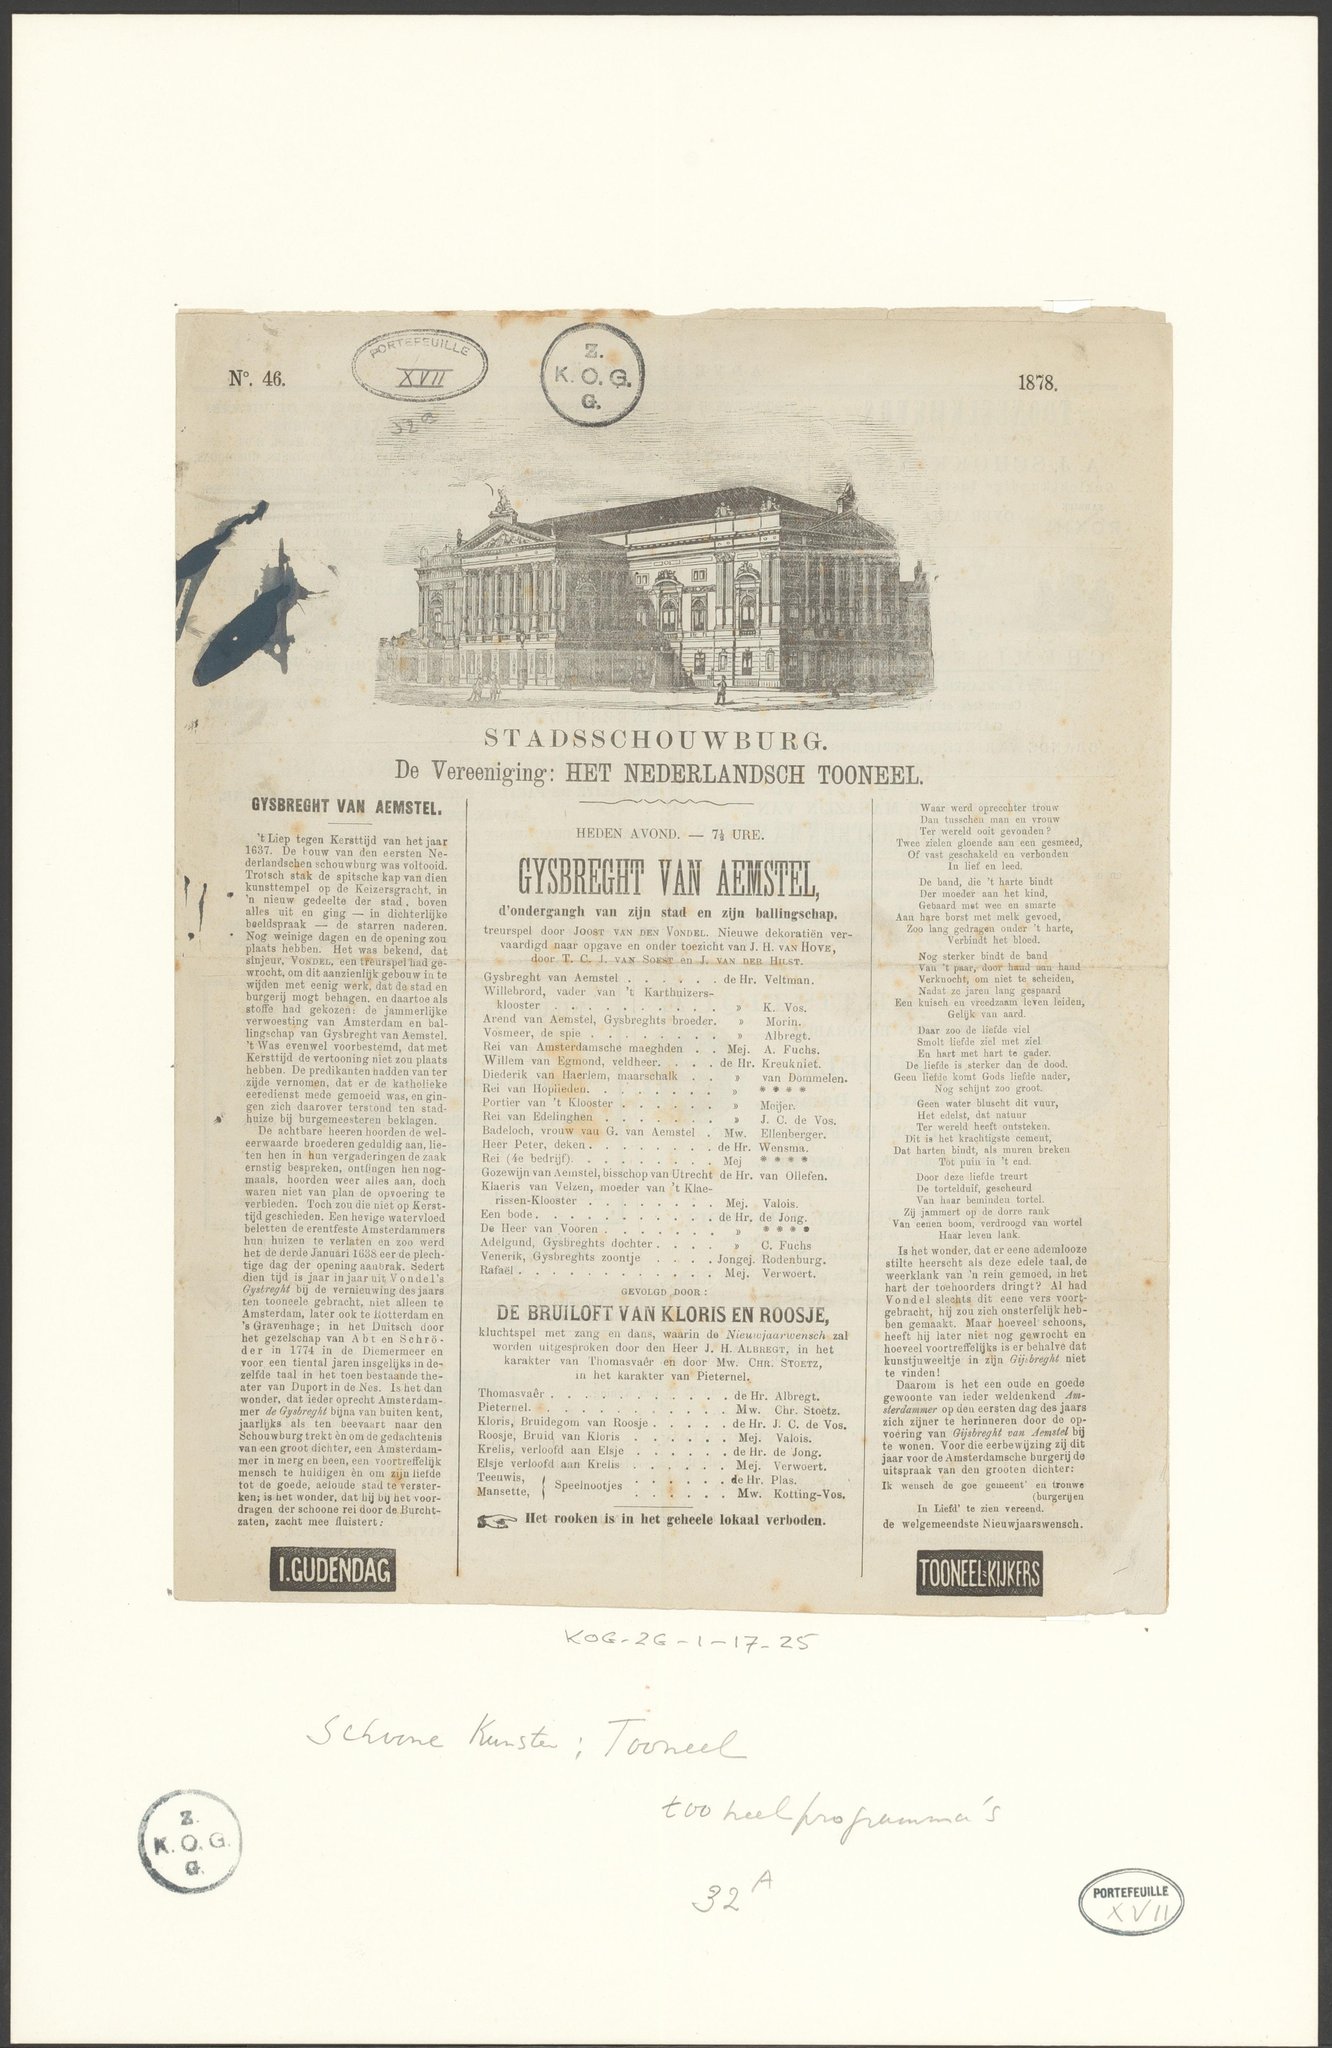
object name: print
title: Aankondiging van de voorstelling Gijsbreght van Aemstel en De bruiloft van Kloris en Roosje, 1878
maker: Anonymous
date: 1878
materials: paper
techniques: letterpress printing, engraving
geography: amsterdam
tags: theatre, theatrical performance, advertisement, notice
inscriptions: collector's mark: Lugt 1641, stamp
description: Een in elkaar gevouwen blad vormt vier pagina's. Op de eerste pagina een aankondiging van de aankomende voorstelling Gijsbeght van Aemstel en De bruiloft van Kloris en Roosje in de Stadsschouwburg in 1878. Op de overige pagina's advertenties. Linksboven genummerd: No. 46. Onderwerpsrubrieken binnen de Atlas Zeden en Gewoonten: Tooneel, Toneelprogramma’s.